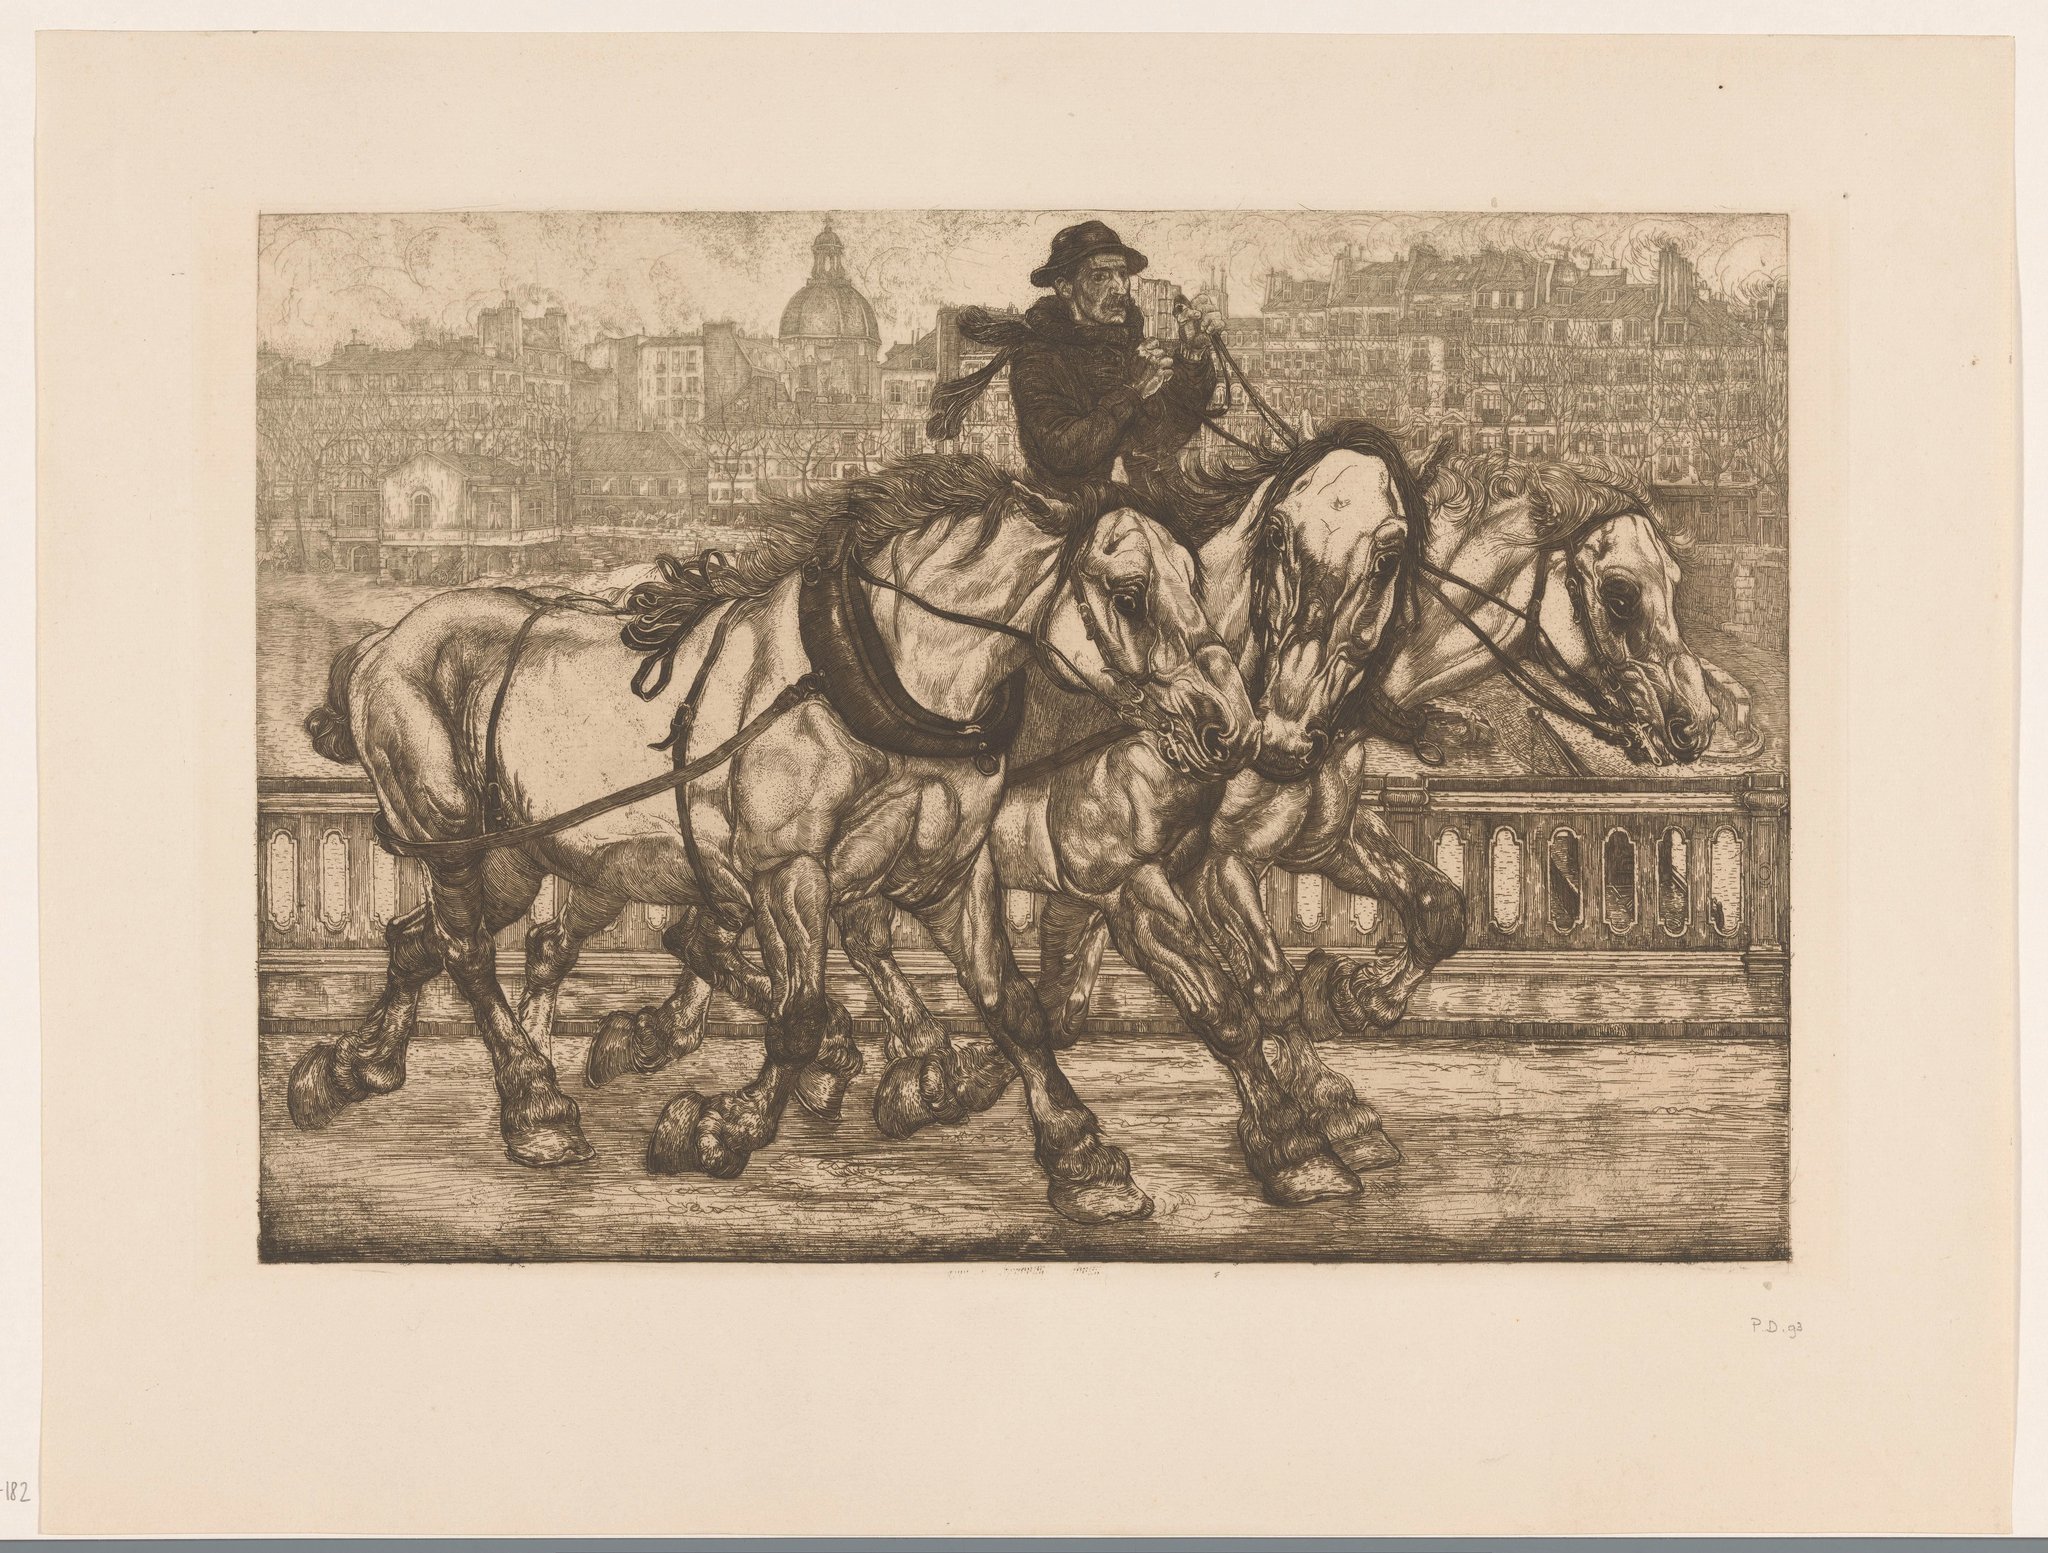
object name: print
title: Drie paarden op de Pont de Sully in Parijs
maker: pieter dupont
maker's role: draughtsman, print maker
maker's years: 1870-1911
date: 1902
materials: paper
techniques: etching, intaglio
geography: paris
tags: painter, martin monnickendam, horse, bridge in city across river, canal, etc.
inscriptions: collector's mark: Lugt 2233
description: De paarden worden door een man met een hoed begeleid. Op de achtergrond de Seine, huizen en de koepel van een kerk, mogelijk de Temple du Marais.